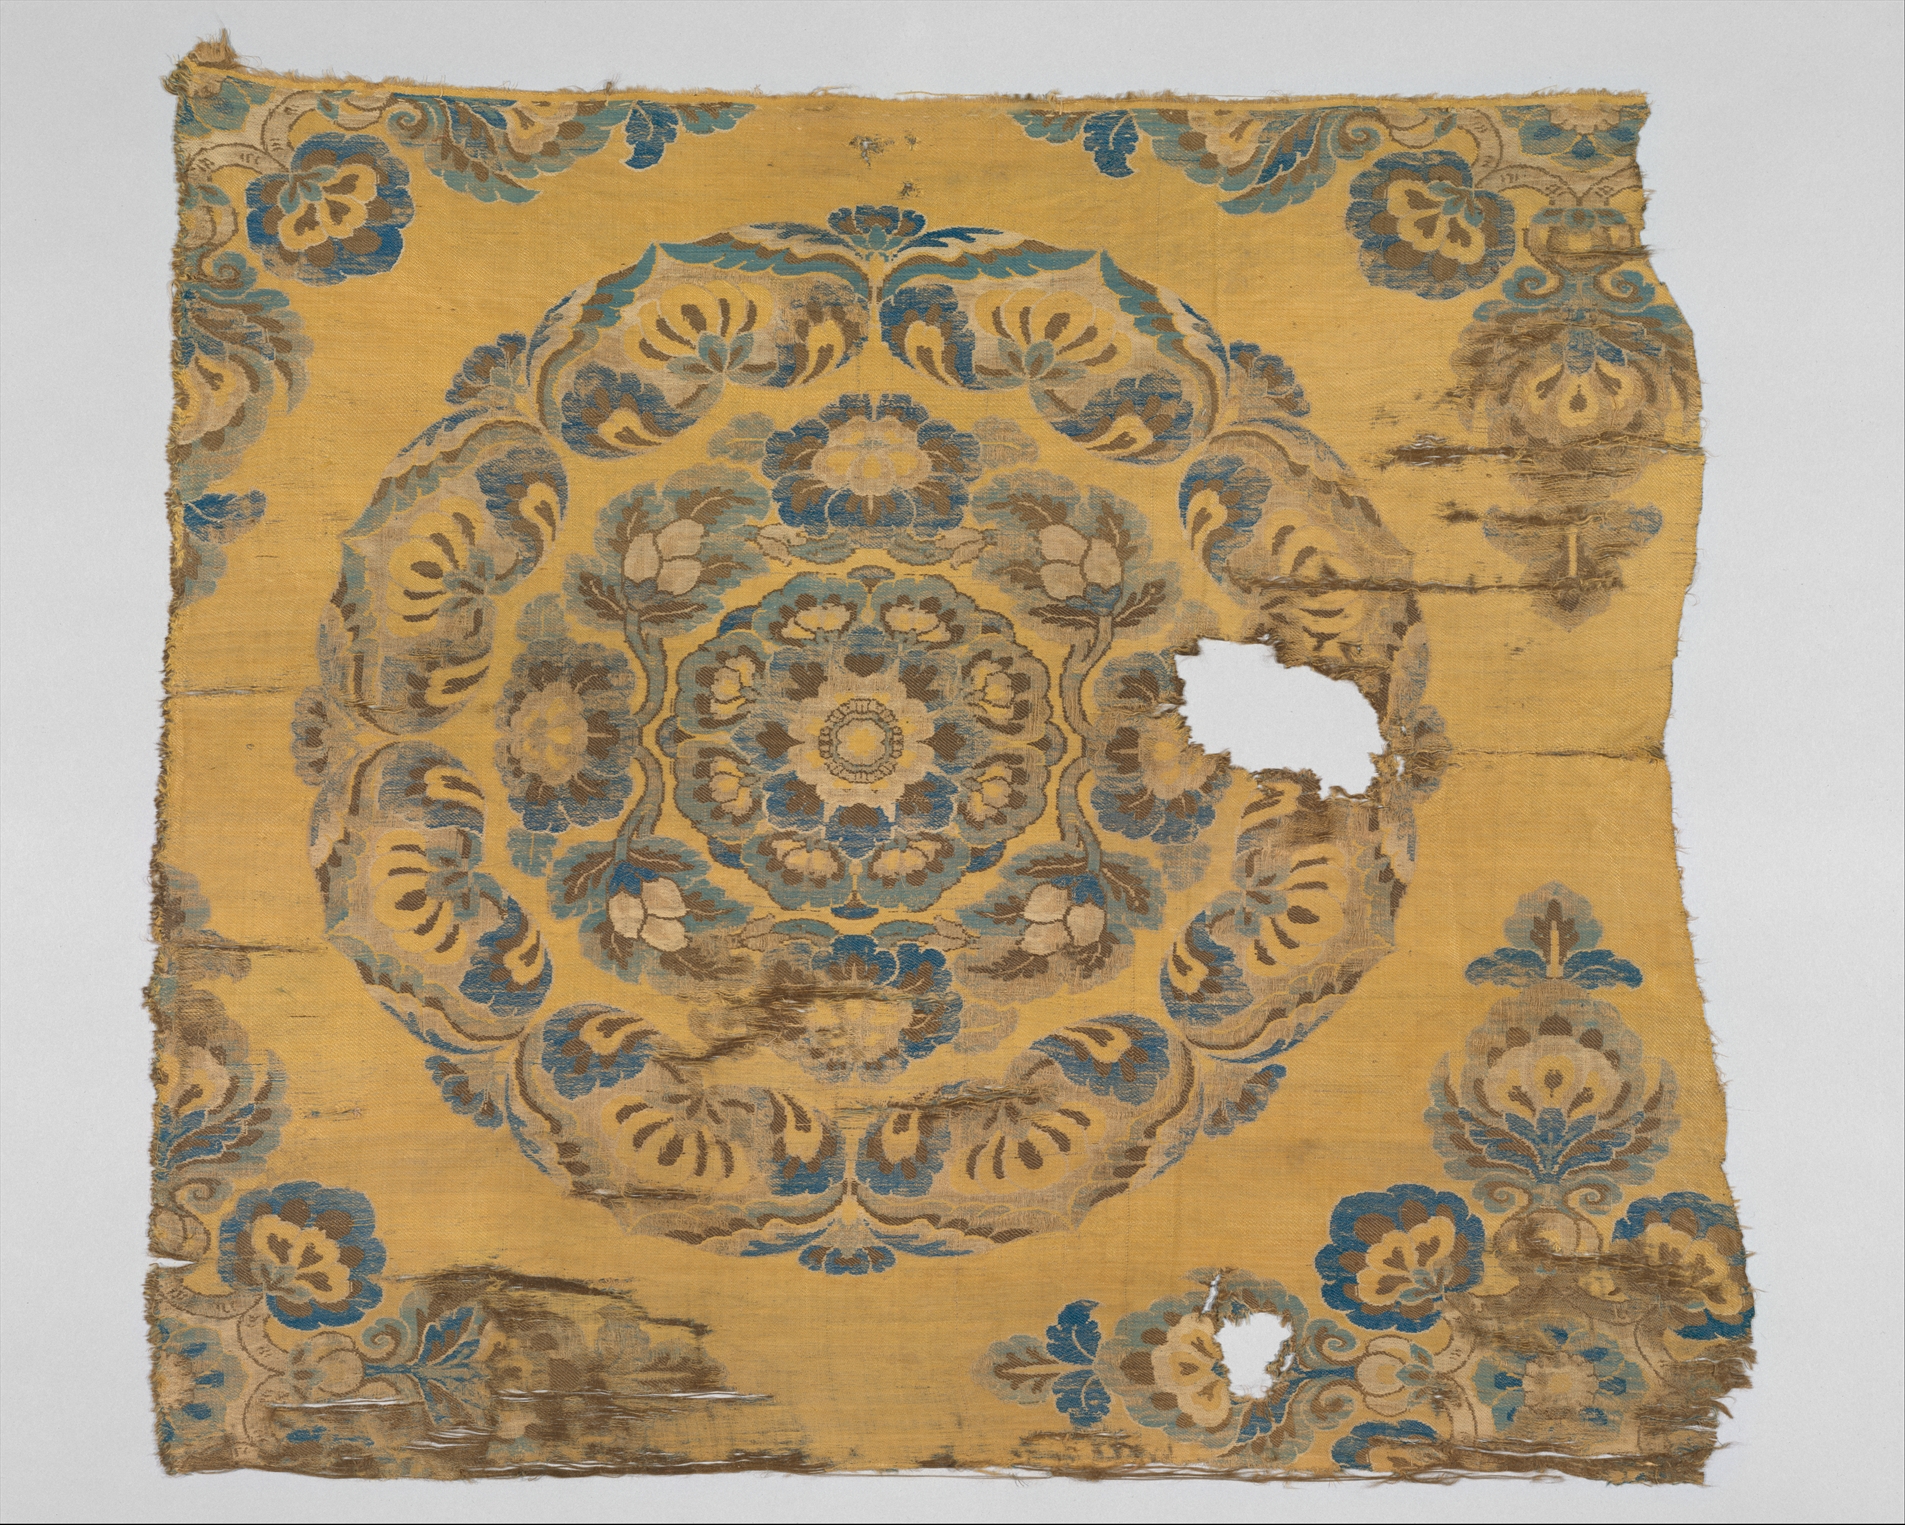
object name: piece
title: Textile with floral medallion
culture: chinese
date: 767-833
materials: silk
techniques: weave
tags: flowers